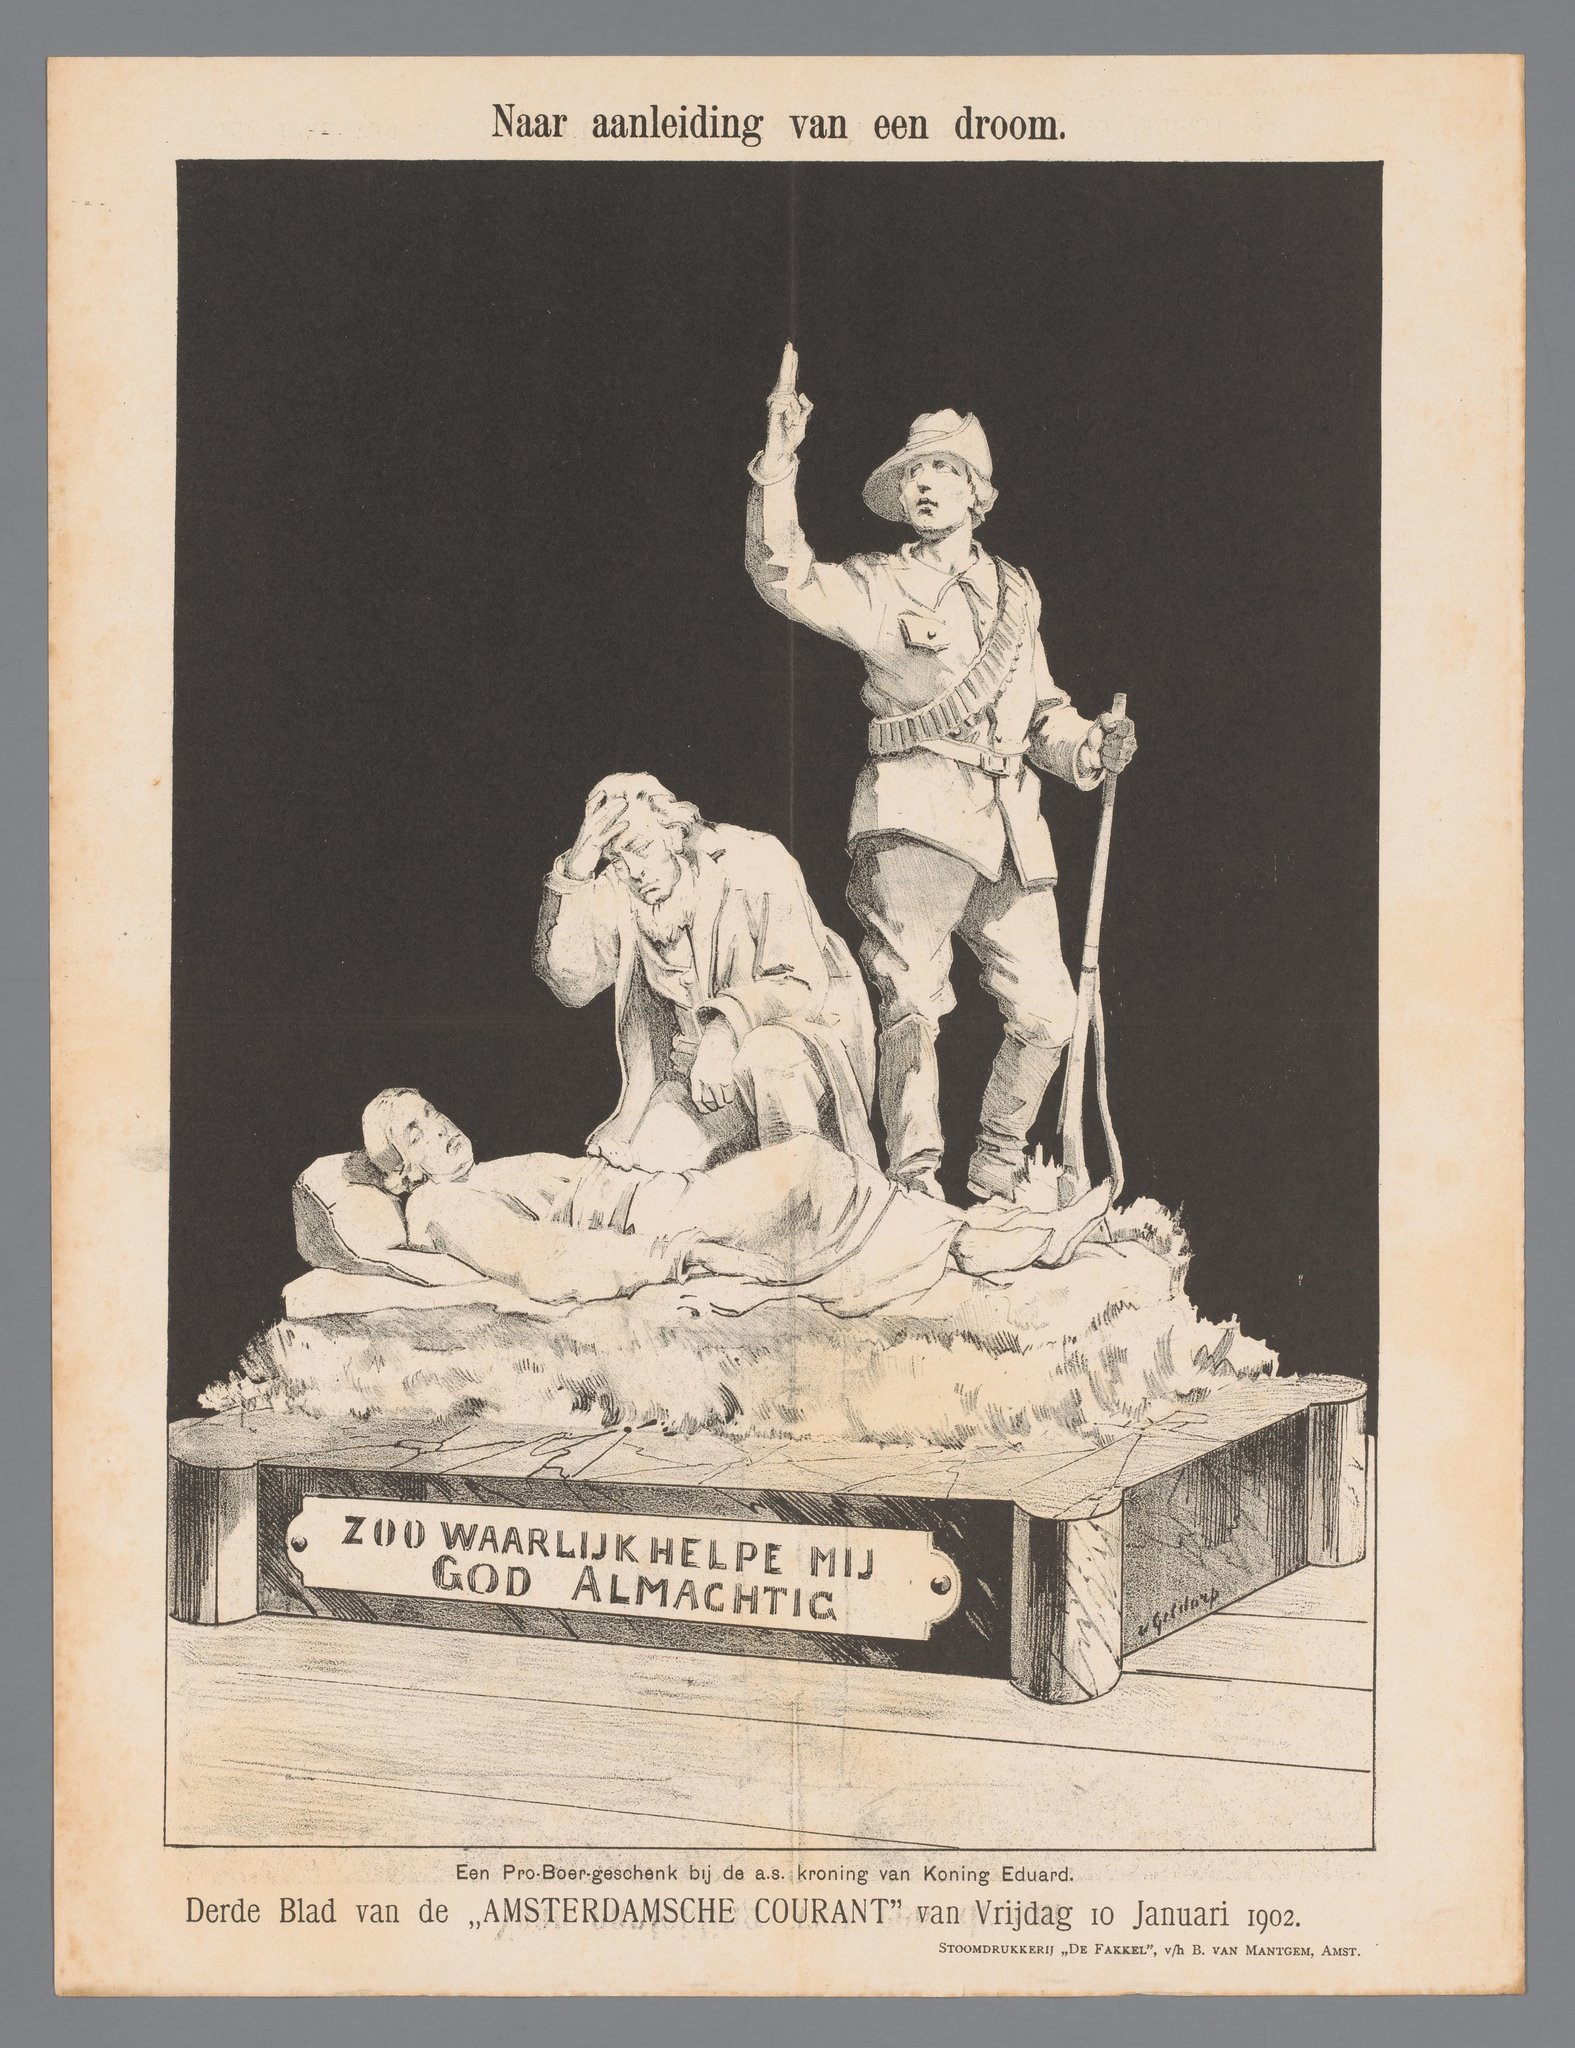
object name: cartoon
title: Naar aanleiding van een droom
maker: petrus van geldorp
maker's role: draughtsman, print maker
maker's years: 1872-1939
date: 1902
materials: paper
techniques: lithograph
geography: amsterdam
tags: historical persons, piece of sculpture, reproduction of a piece of sculpture, political caricatures and satires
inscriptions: date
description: Prent uit het bijvoegsel van: De Amsterdamsche Courant, 10 januari 1902.